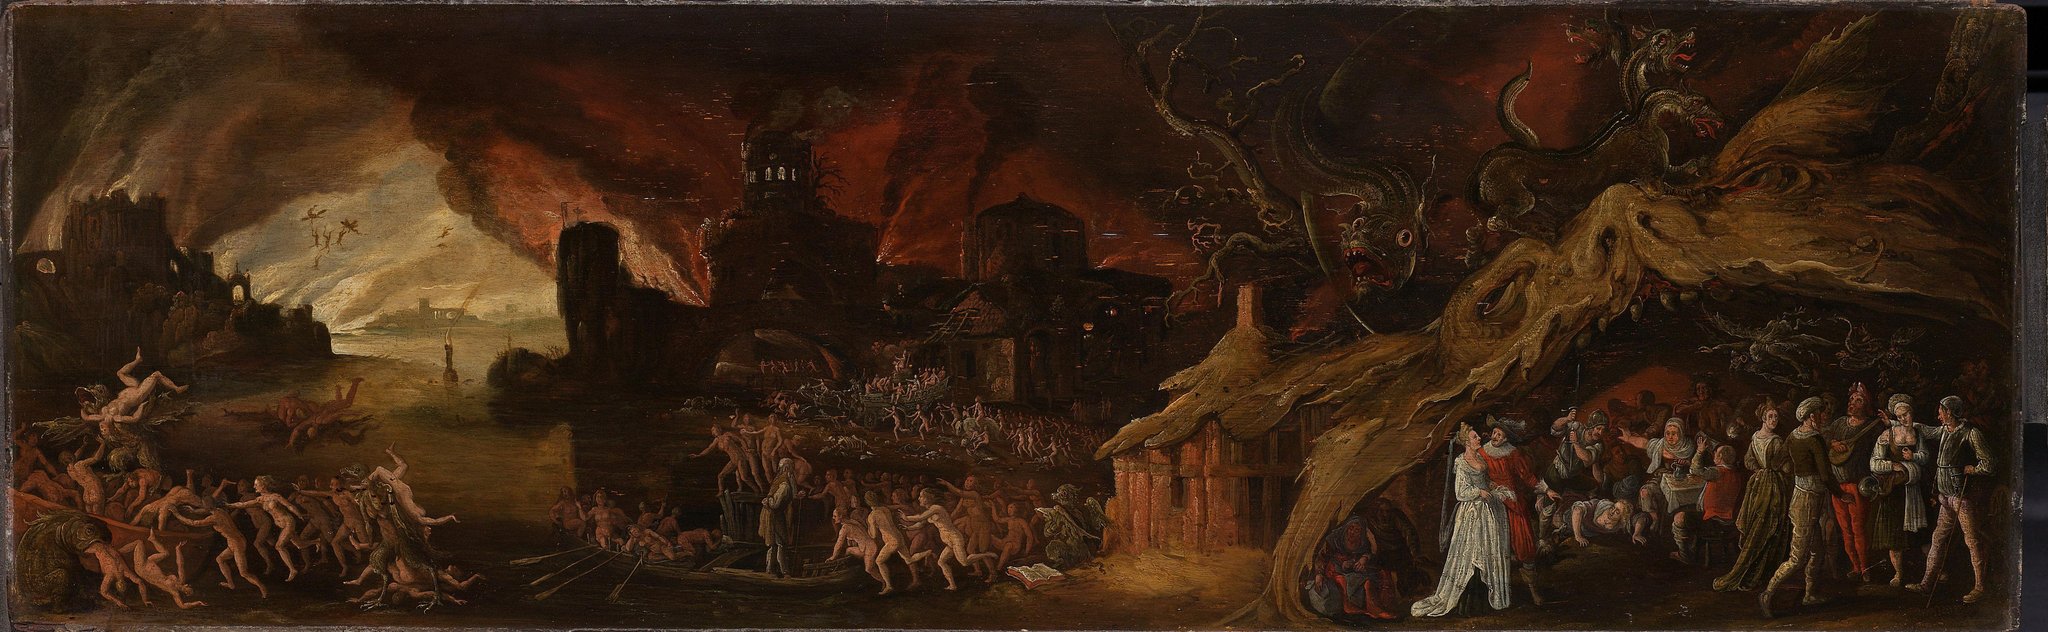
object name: painting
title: The Last Judgment and the Seven Deadly Sins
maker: jacob isaacsz. van swanenburg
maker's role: draughtsman, painter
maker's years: 1571-1638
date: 1600-1638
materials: oil, panel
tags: entrance of hell as monstrous mouth (of leviathan) in a landscape, last judgement, the seven deadly sins (personified)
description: Het laatste oordeel en de zeven hoofdzonden. De hel waarin de naakte verdoemden in groepen uitzwermen over het land en water, rechts een grote hellemond waarin de hoofdzonden door figuren worden verbeeld. Overal vliegen duivels en monsters, links enkele grote gebouwen en vlammen,